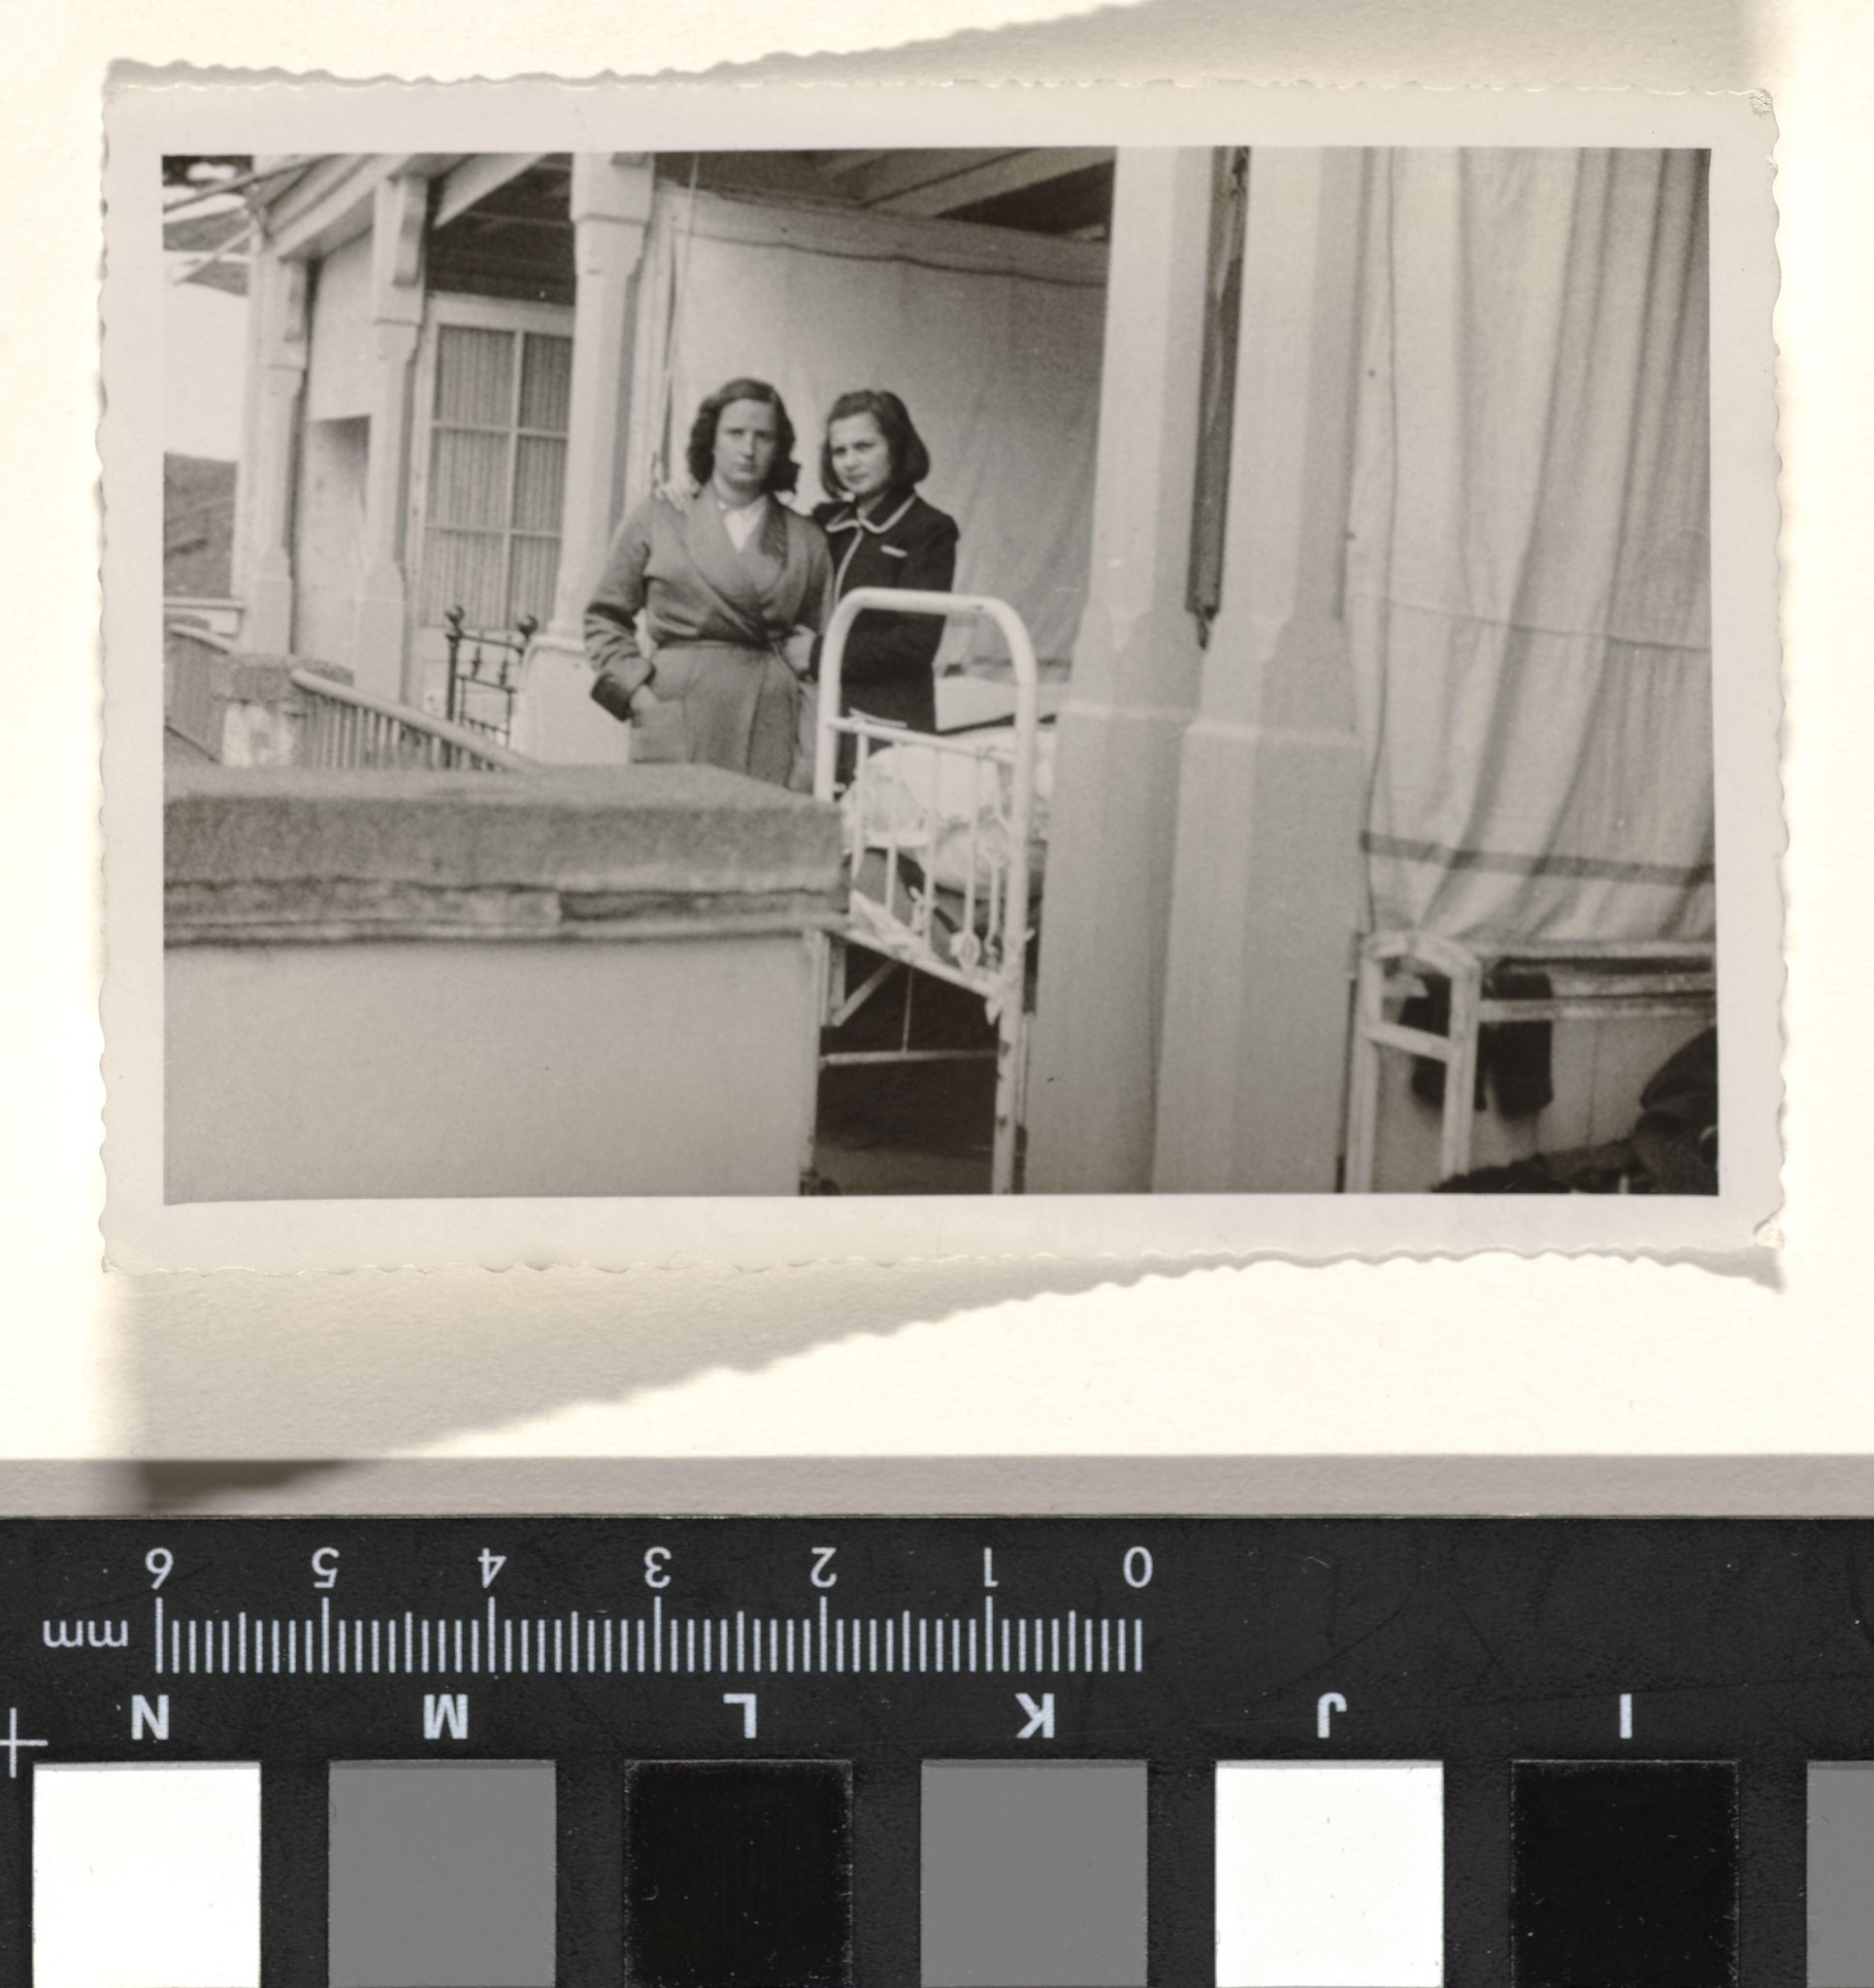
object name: photograph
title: Isabel Wachenheimer in kamerjas staand voor de toegang tot een openlucht ziekenhuiskamer in het Joods sanatorium Etania met een onbekende vrouw in Davos, april 1946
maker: Anonymous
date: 1904-1946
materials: photographic support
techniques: gelatin silver print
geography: davos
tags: leiden, isabel wachenheimer-elon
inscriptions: date: ‘Davos April 1946.’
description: Isabel Wachenheimer in kamerjas staand voor de toegang tot een openlucht ziekenhuiskamer in het Joods sanatorium Etania met een onbekende vrouw in Davos.